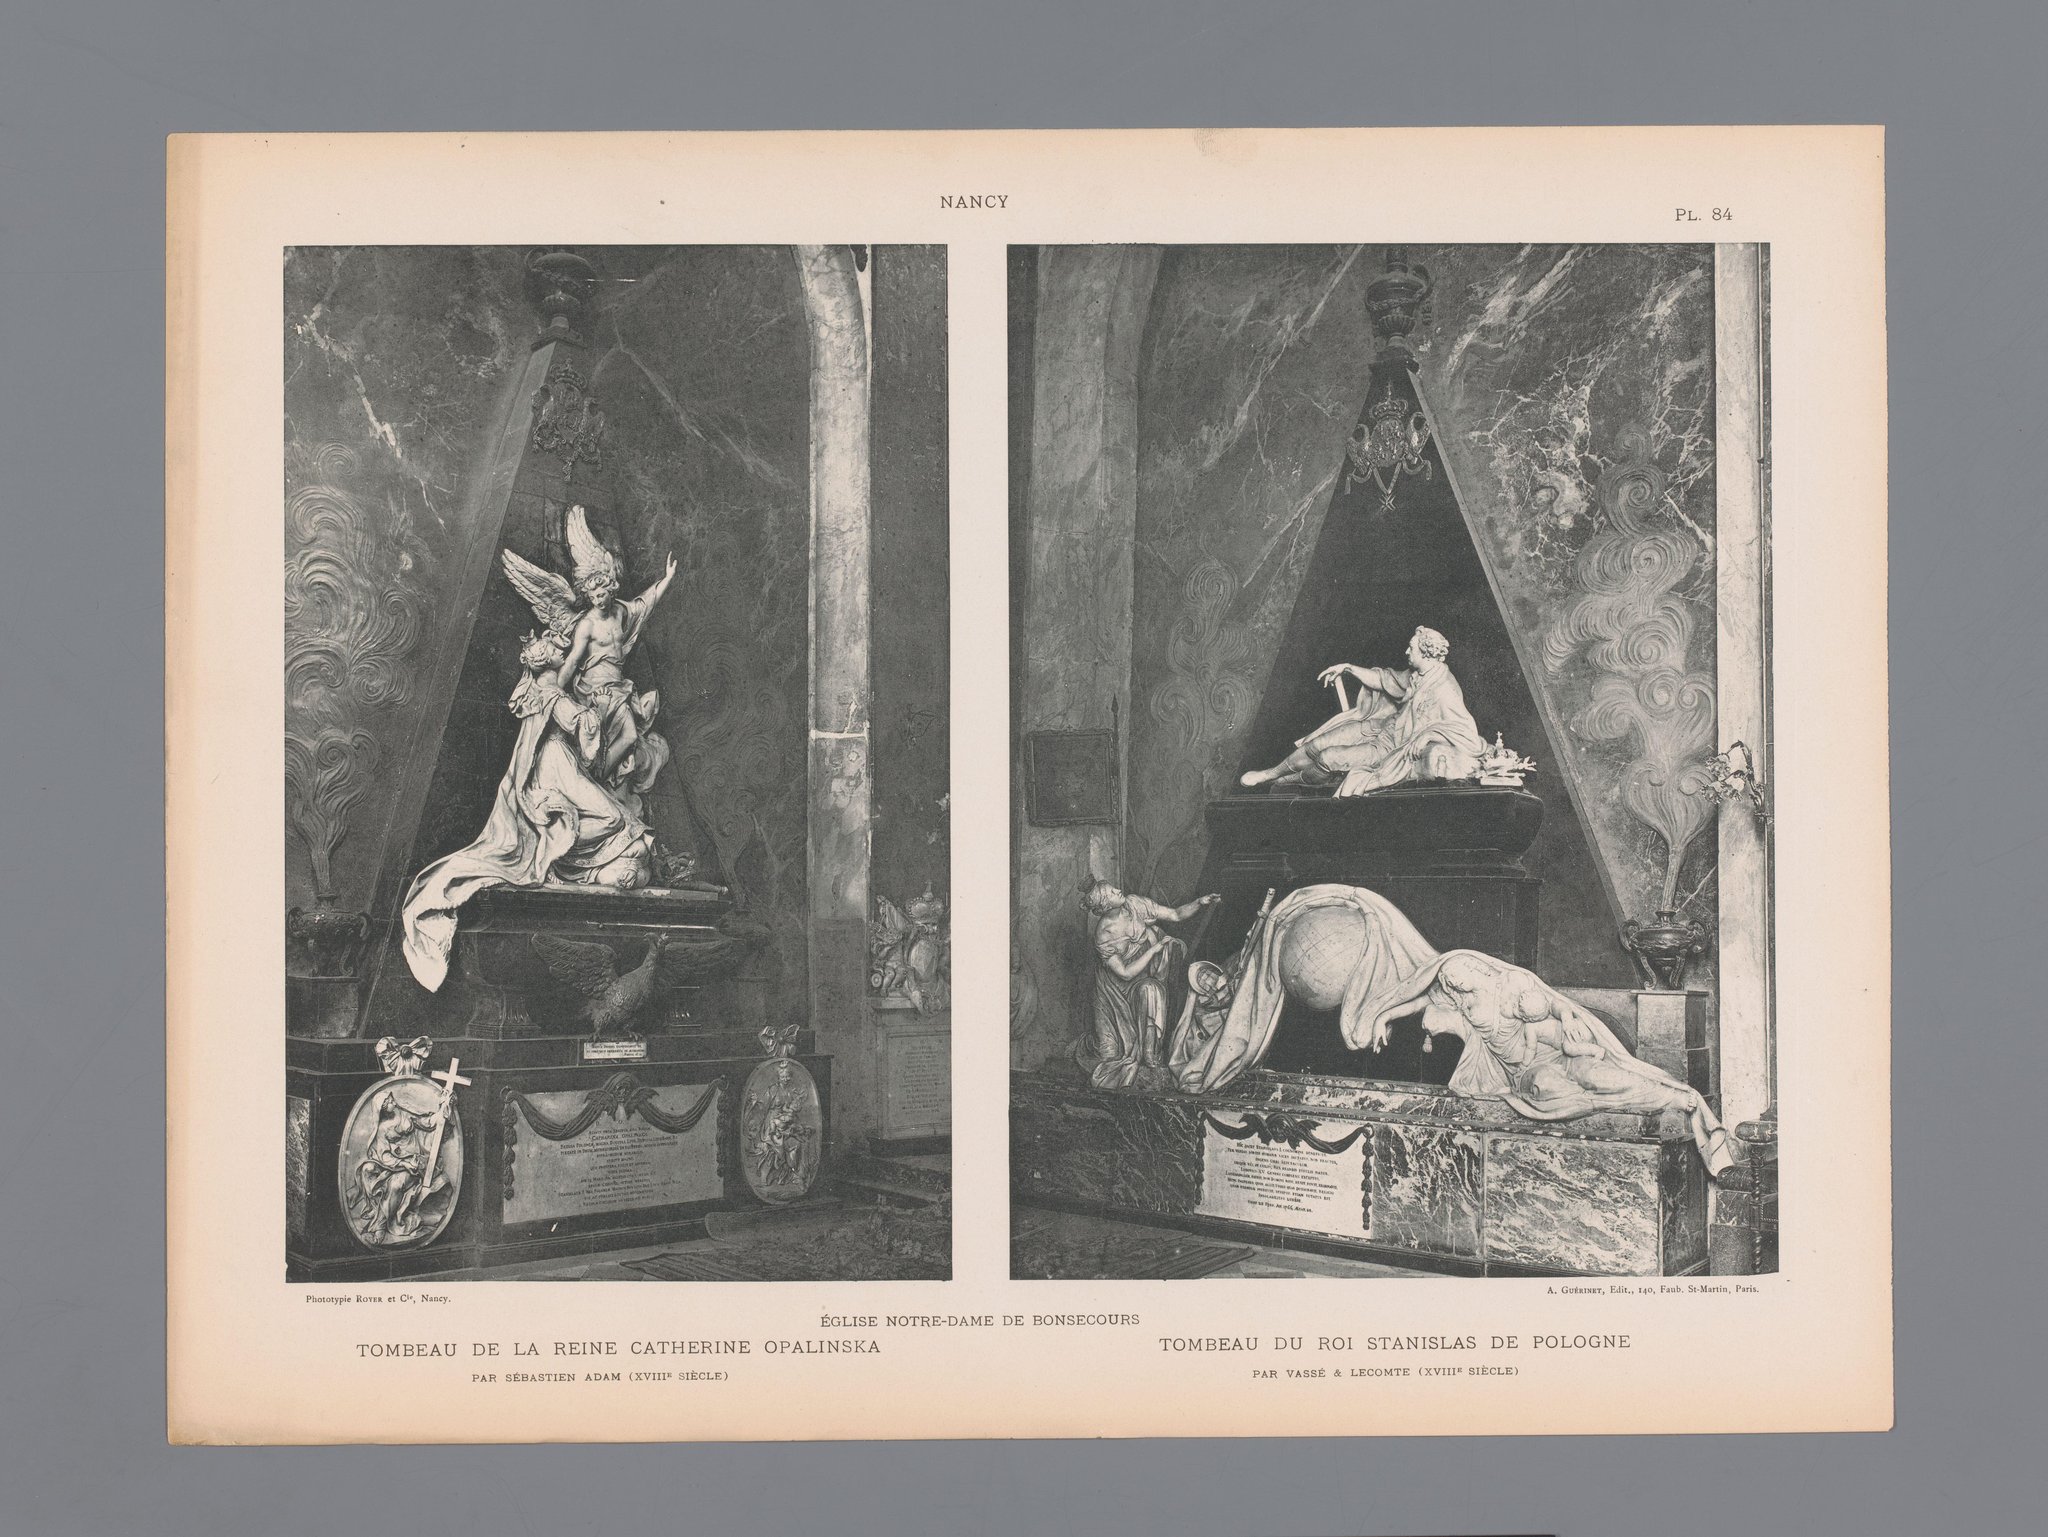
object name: photomechanical print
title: Grafmonument van Catherine Opalińska, koningin van Polen, in de Église Notre-Dame-de-Bonsecours te Nancy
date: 1891-1896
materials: paper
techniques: photograph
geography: paris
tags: grave-building, monumental tomb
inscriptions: inscription: ‘Tombeau de la Reine Catherine Opalinska/ par Sébastien Adam (...)’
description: Deze prent maakt deel uit van een omslag met 103 prenten op 101 bladen en een titelblad.